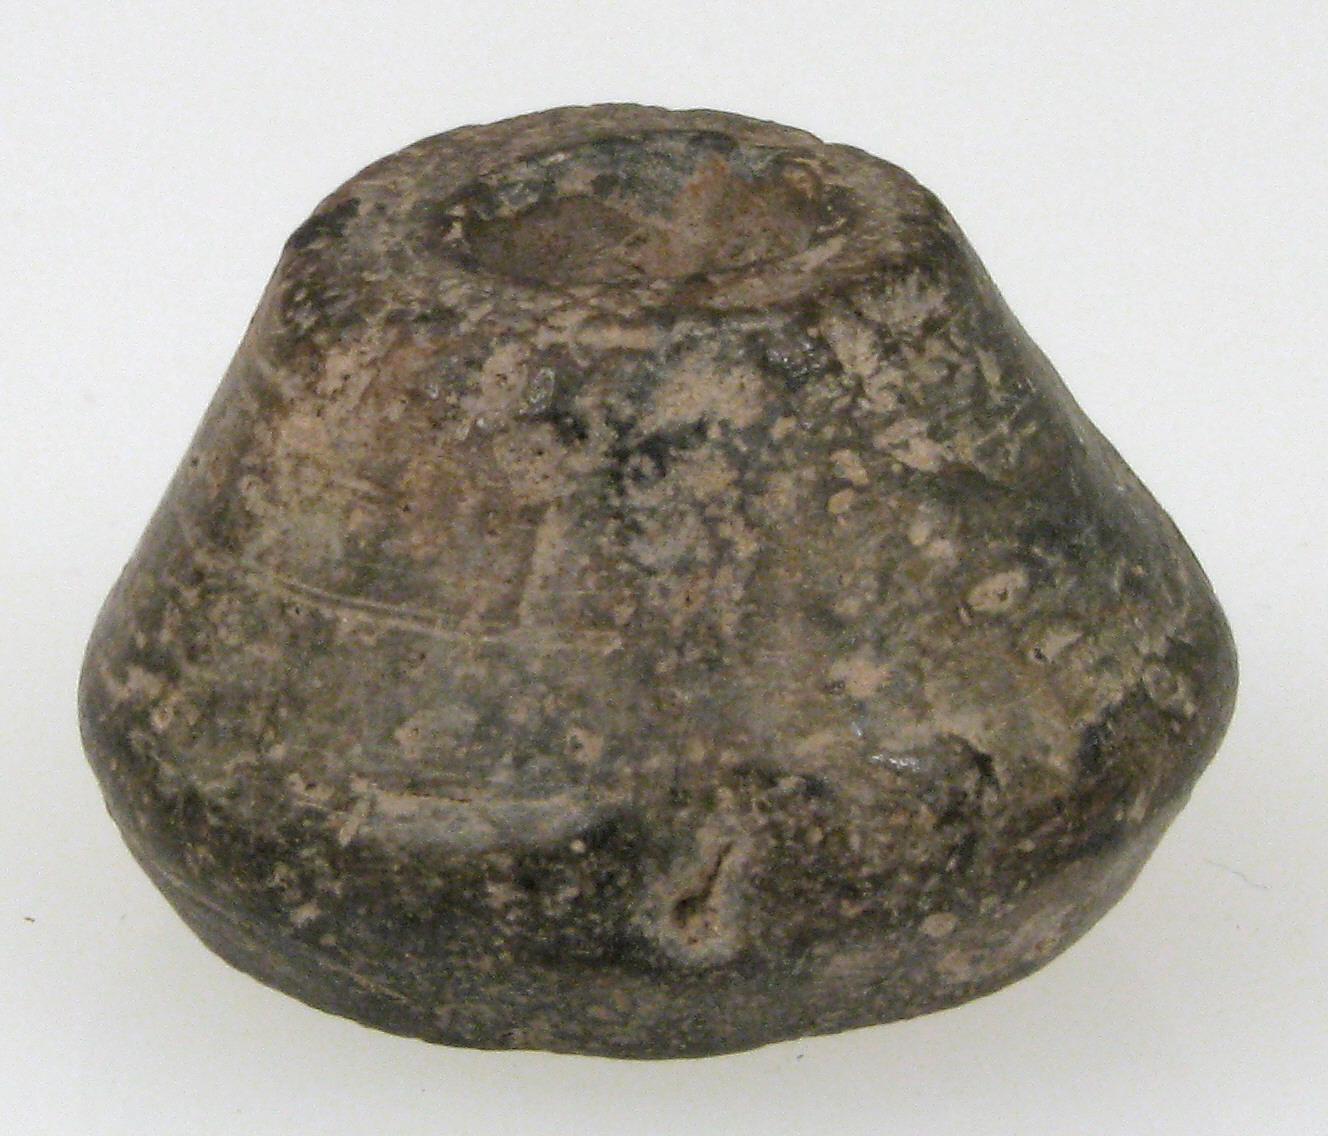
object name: bead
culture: frankish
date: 500-600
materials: stone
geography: germany